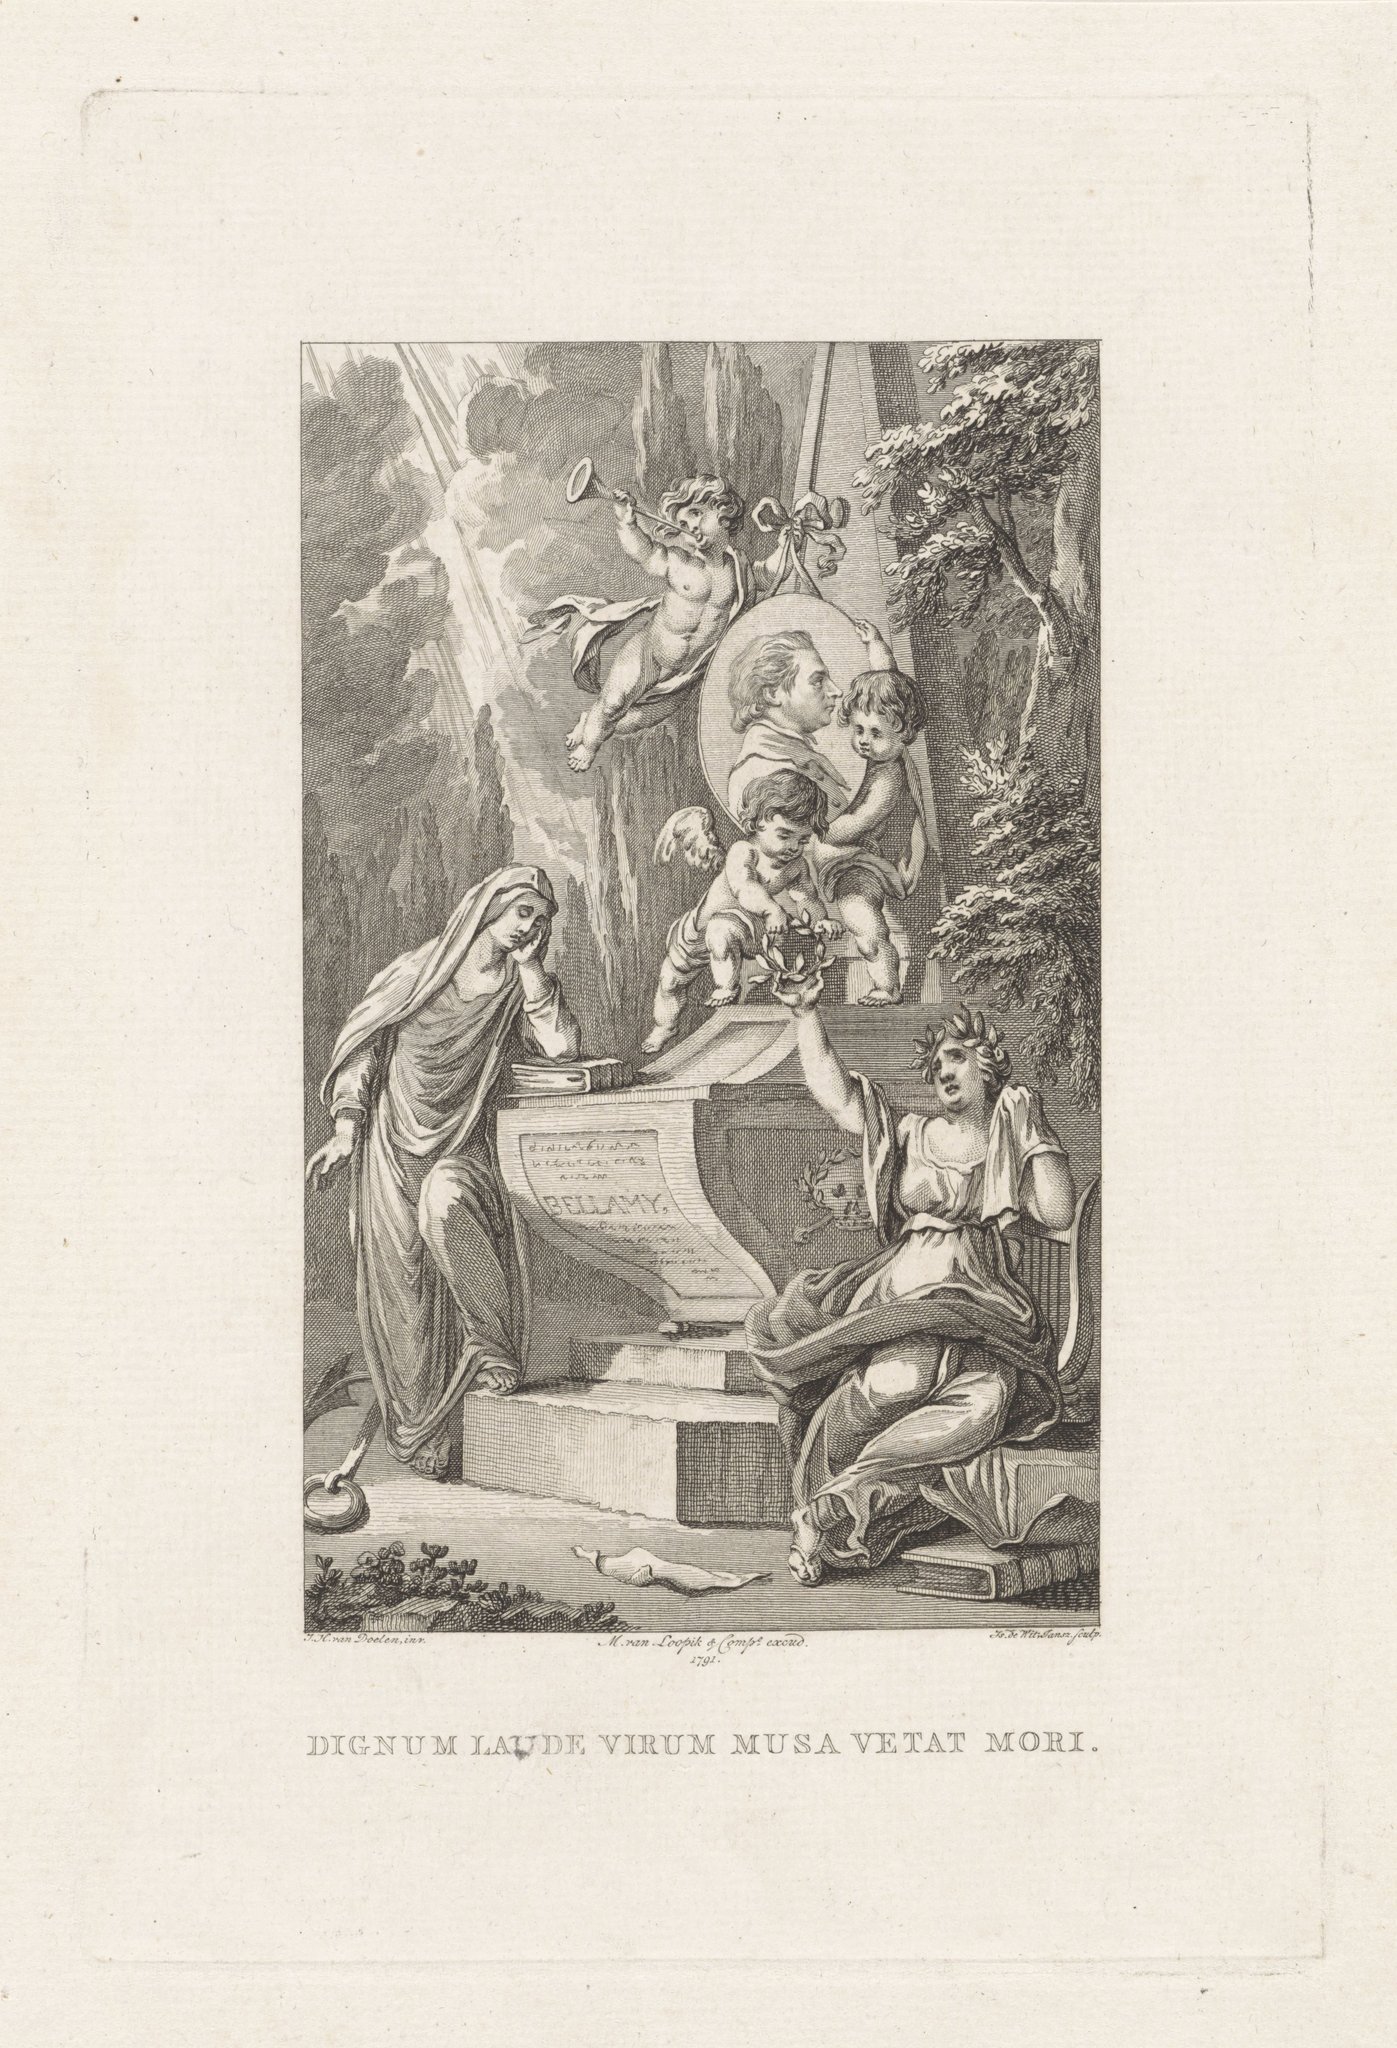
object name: print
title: Monument voor de dichter Jacques Bellamy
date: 1791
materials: paper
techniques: engraving, etching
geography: gouda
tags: flushing, utrecht, lyre, cithara, psaltery, needle, obelisk (marking grave), cupids: 'amores', 'amoretti', 'putti'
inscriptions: collector's mark: Lugt Lugt 2228